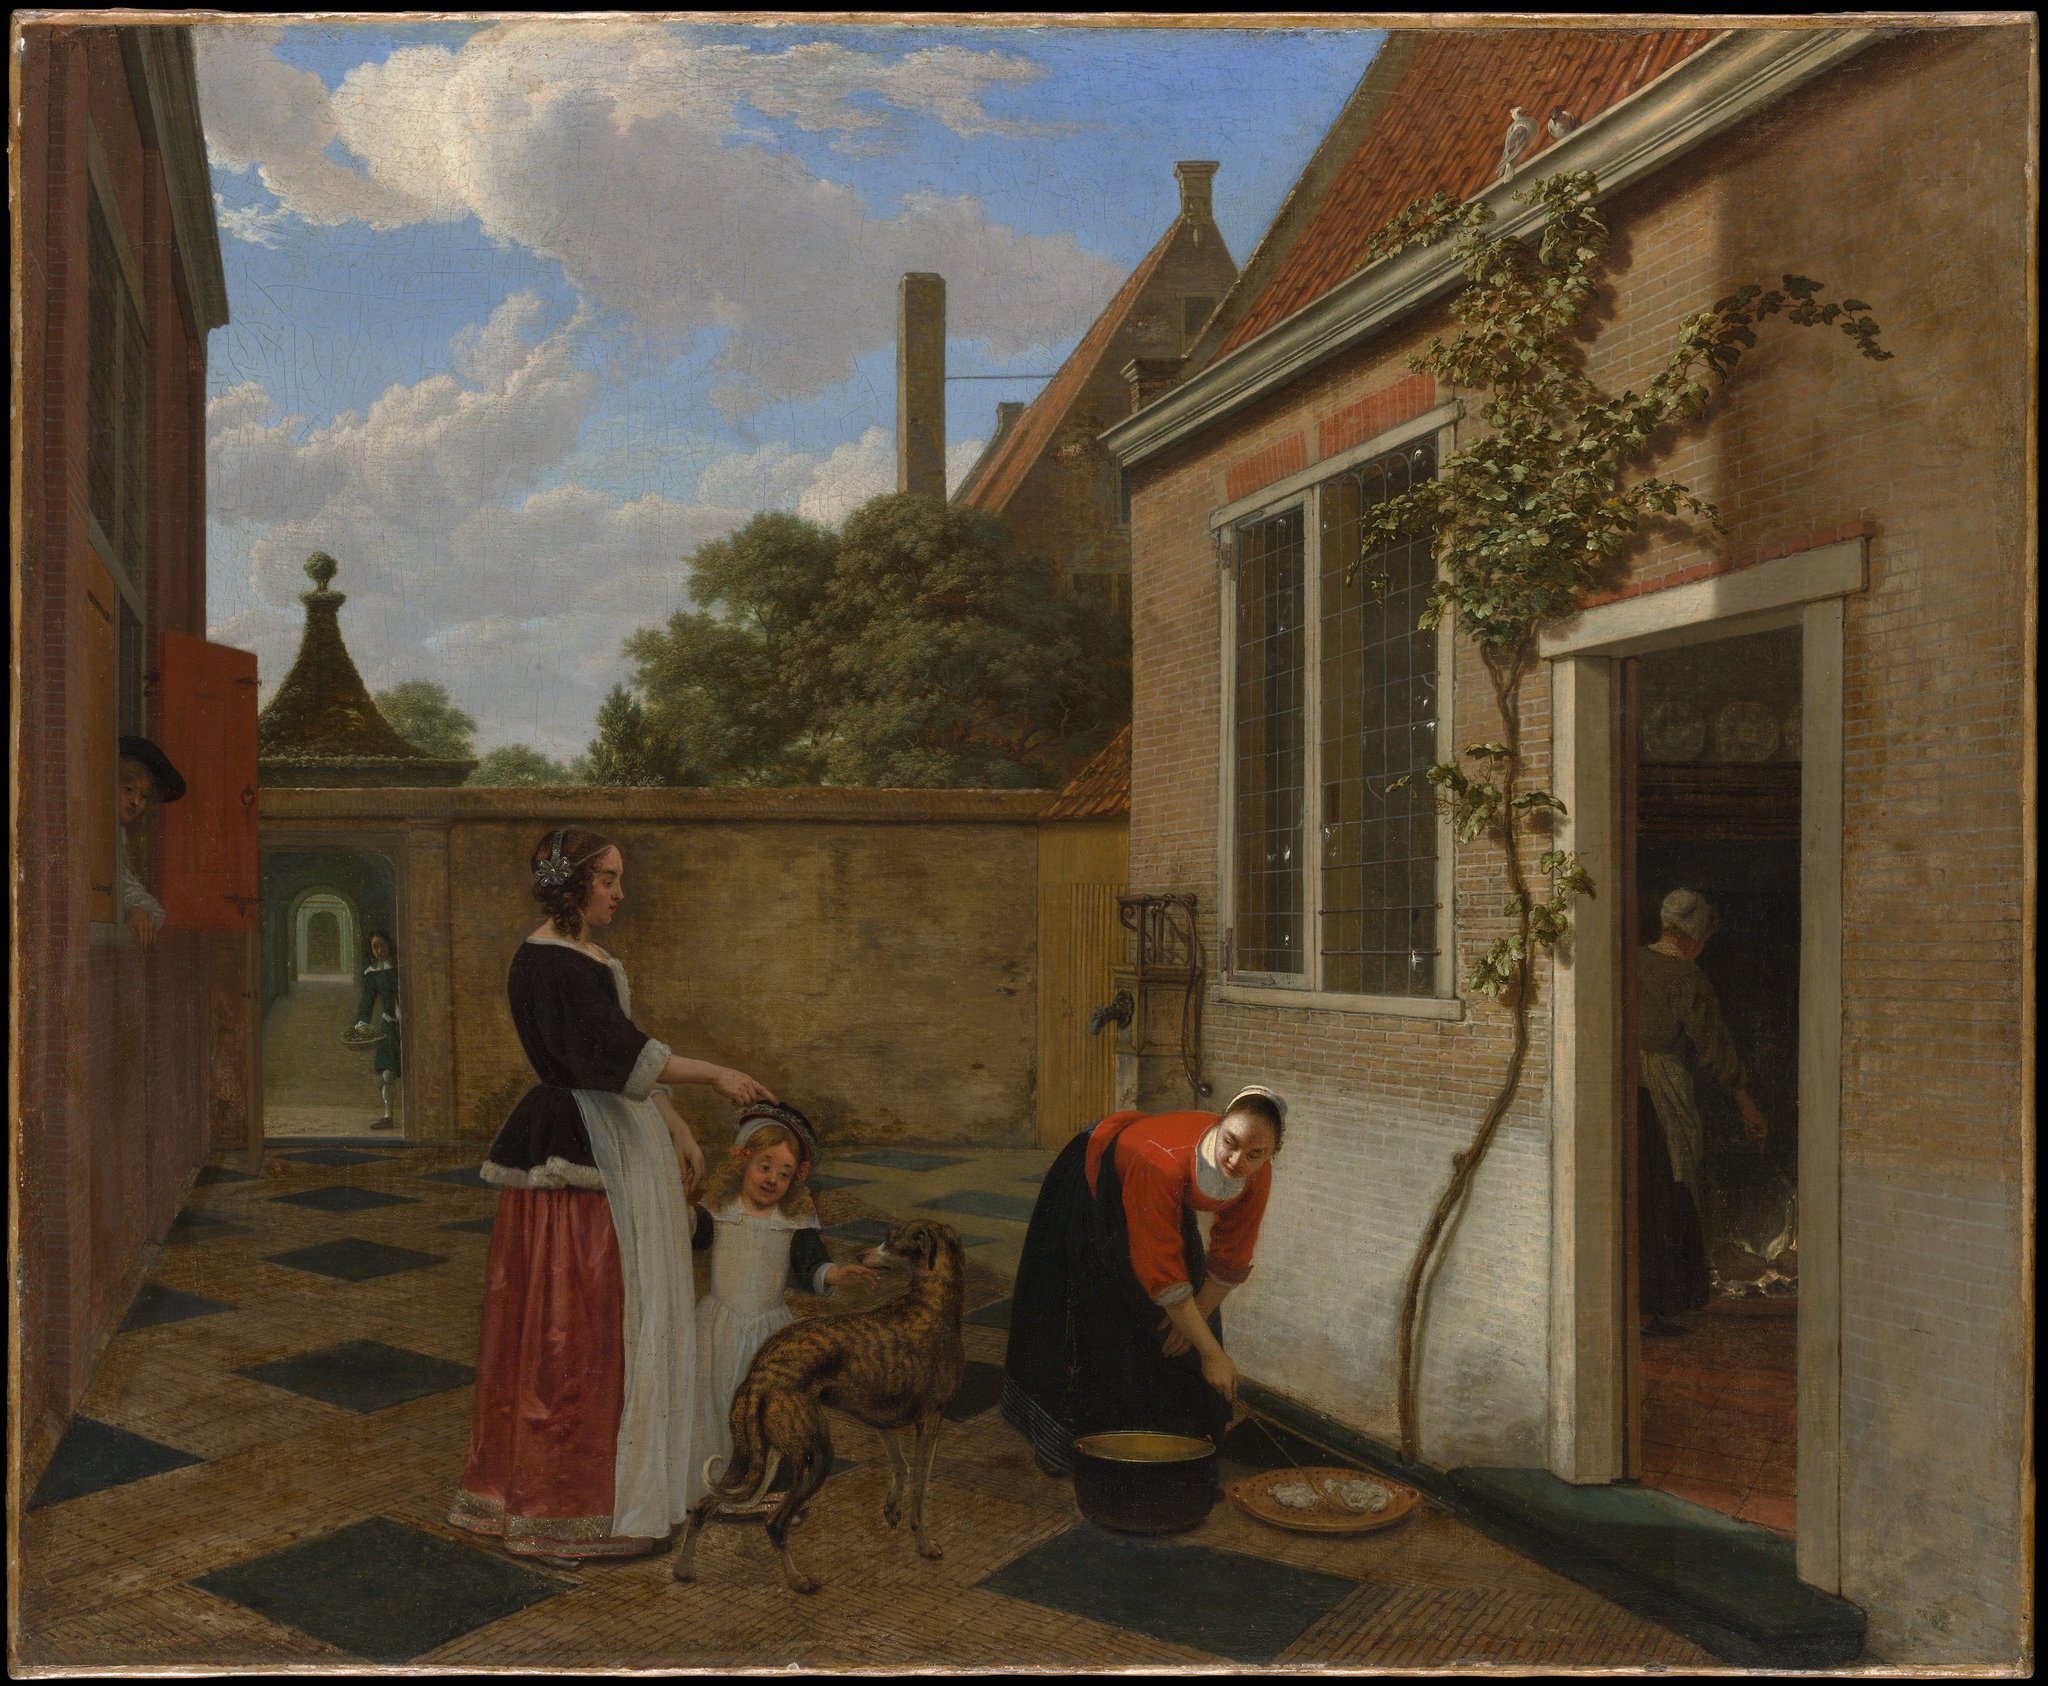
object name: painting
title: Scene in a Courtyard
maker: ludolf de jongh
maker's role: artist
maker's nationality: dutch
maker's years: 1616-1679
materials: canvas, oil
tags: houses,courtyards,girls,women,dogs